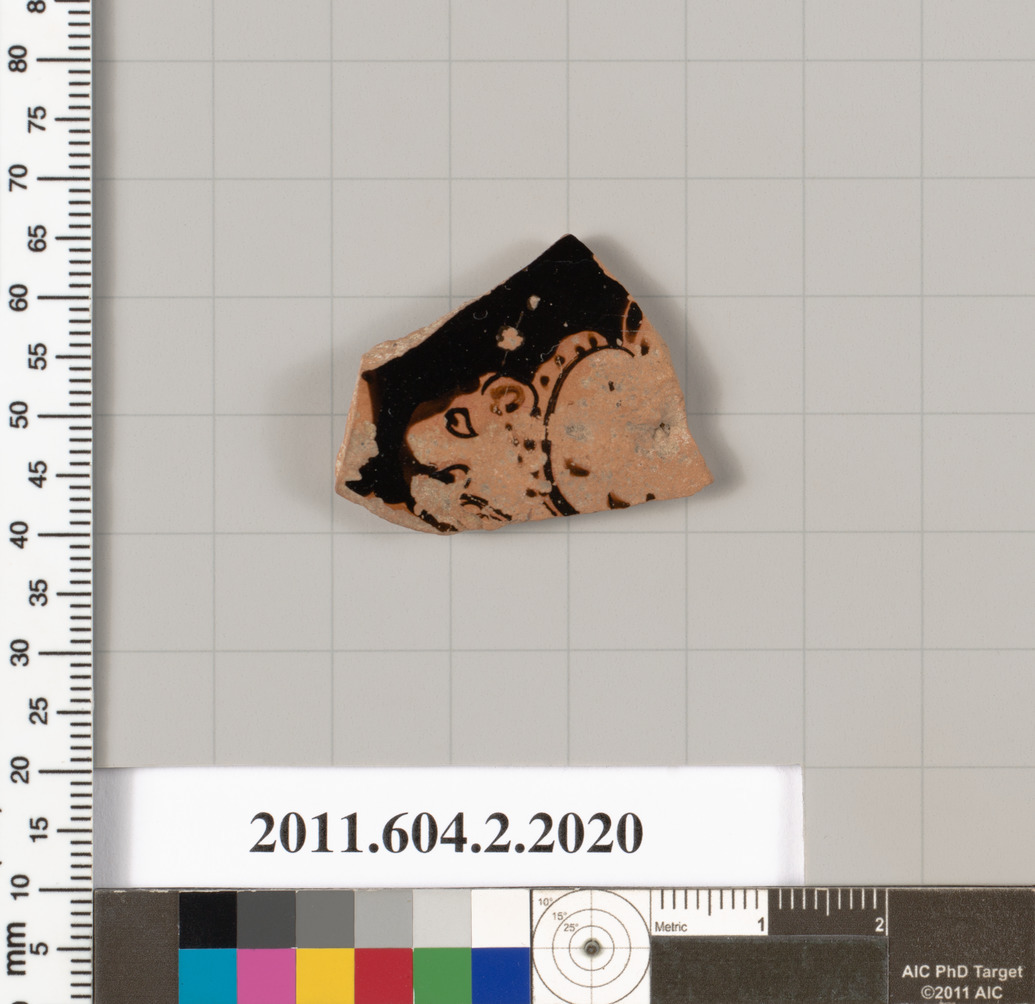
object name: askos fragment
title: Terracotta fragment of an askos (flask with a spout and handle over the top)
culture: greek, attic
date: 420-410 BCE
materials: terracotta